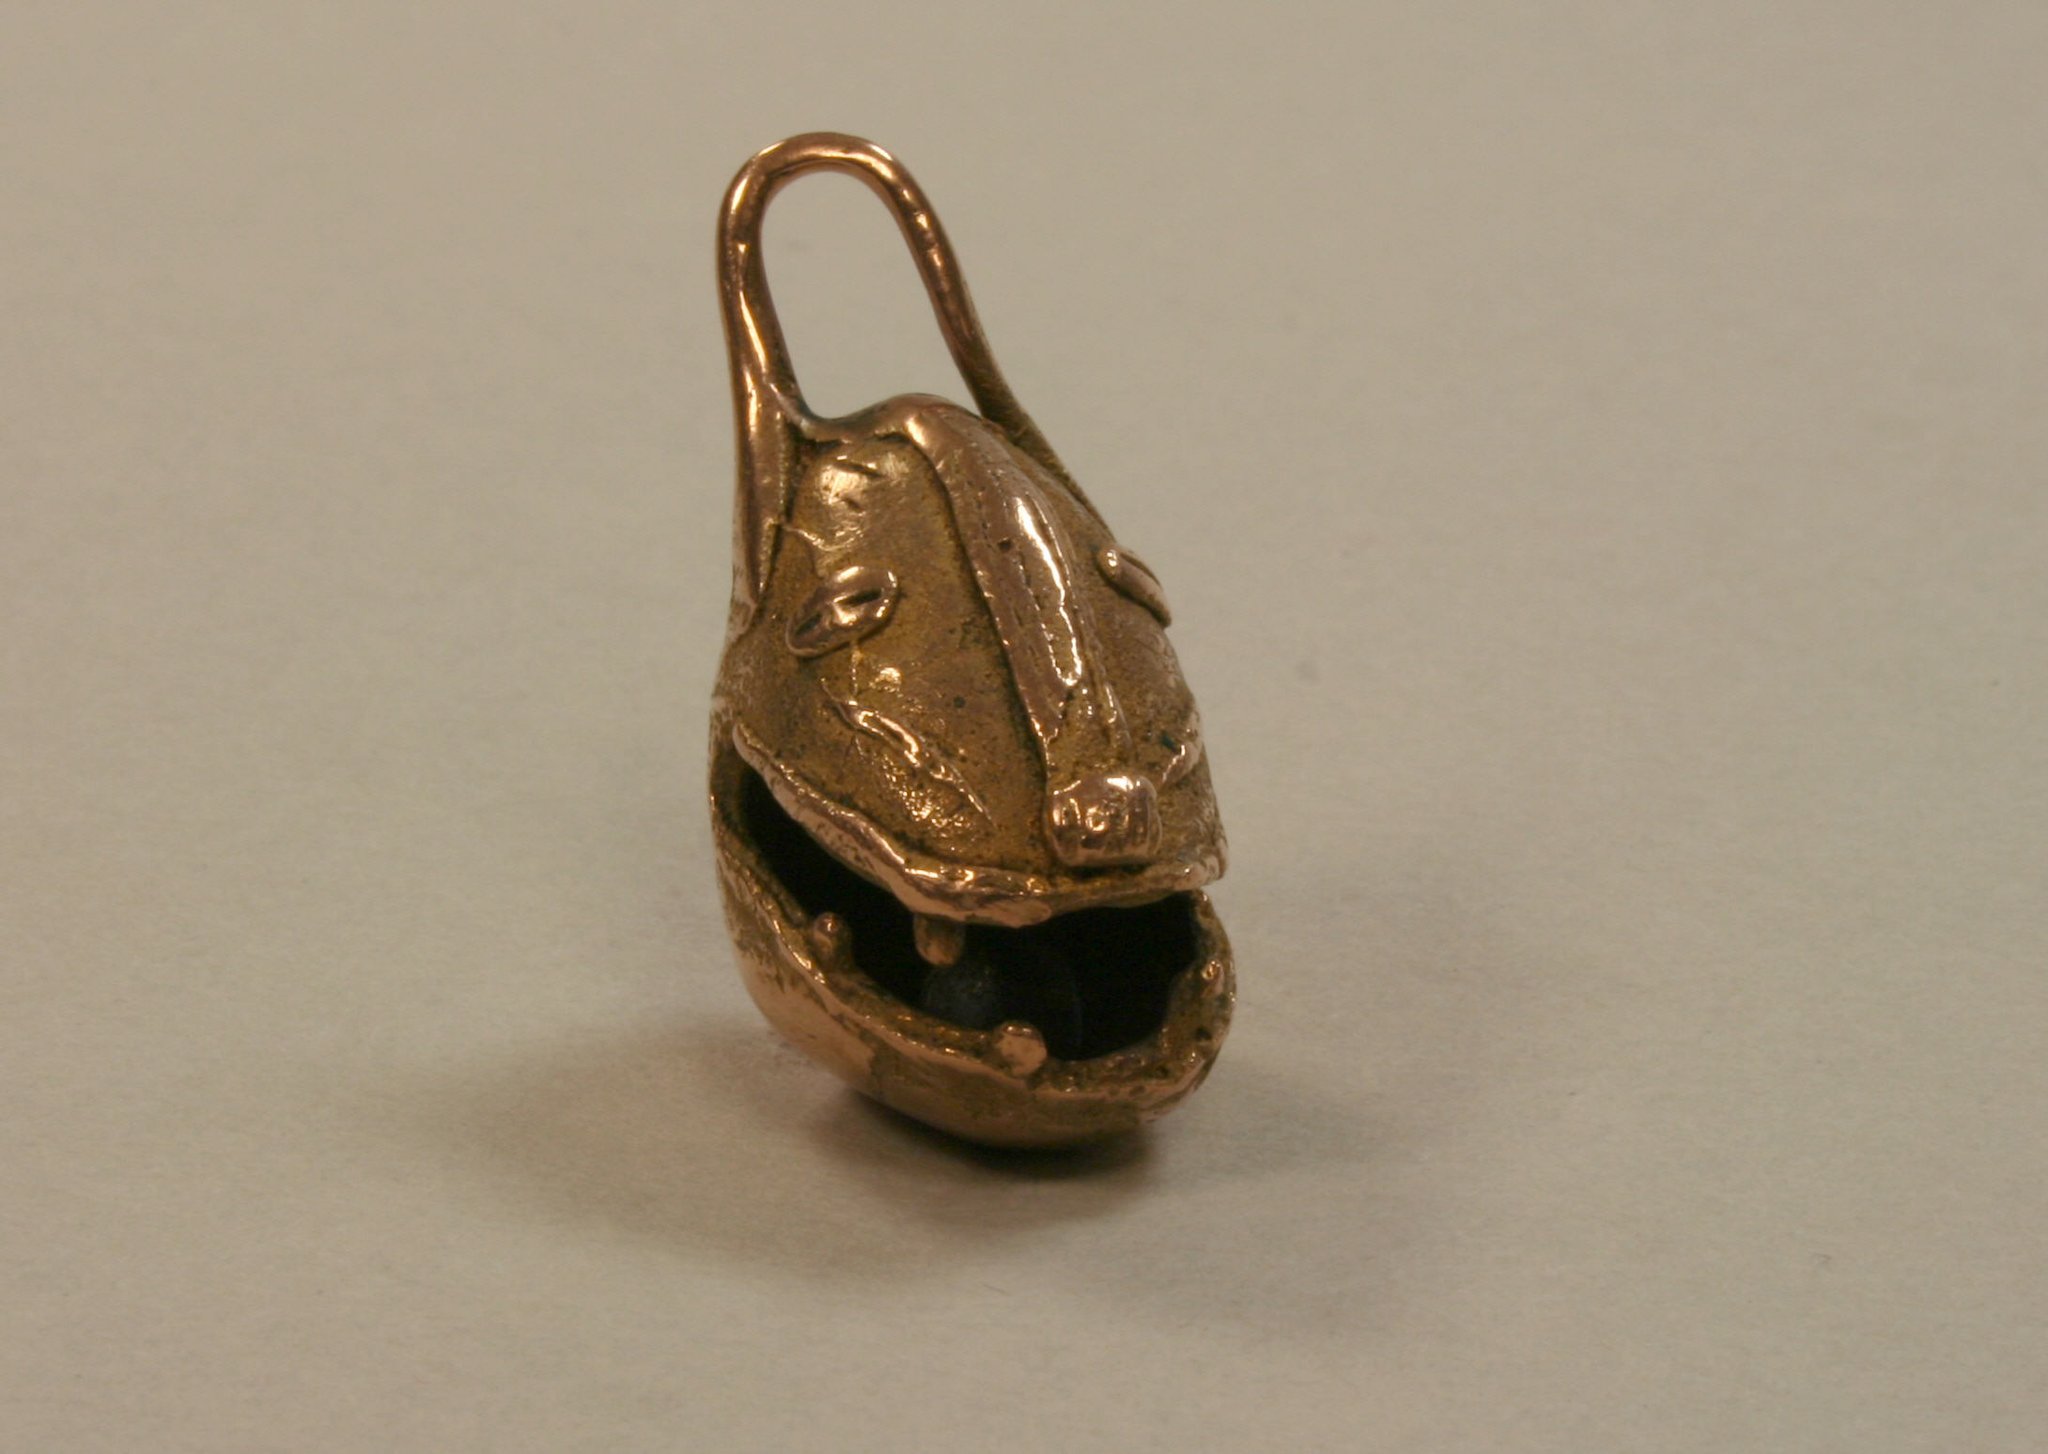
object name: bell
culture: greater chiriquí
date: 900-1520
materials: gold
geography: costa rica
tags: musical instruments